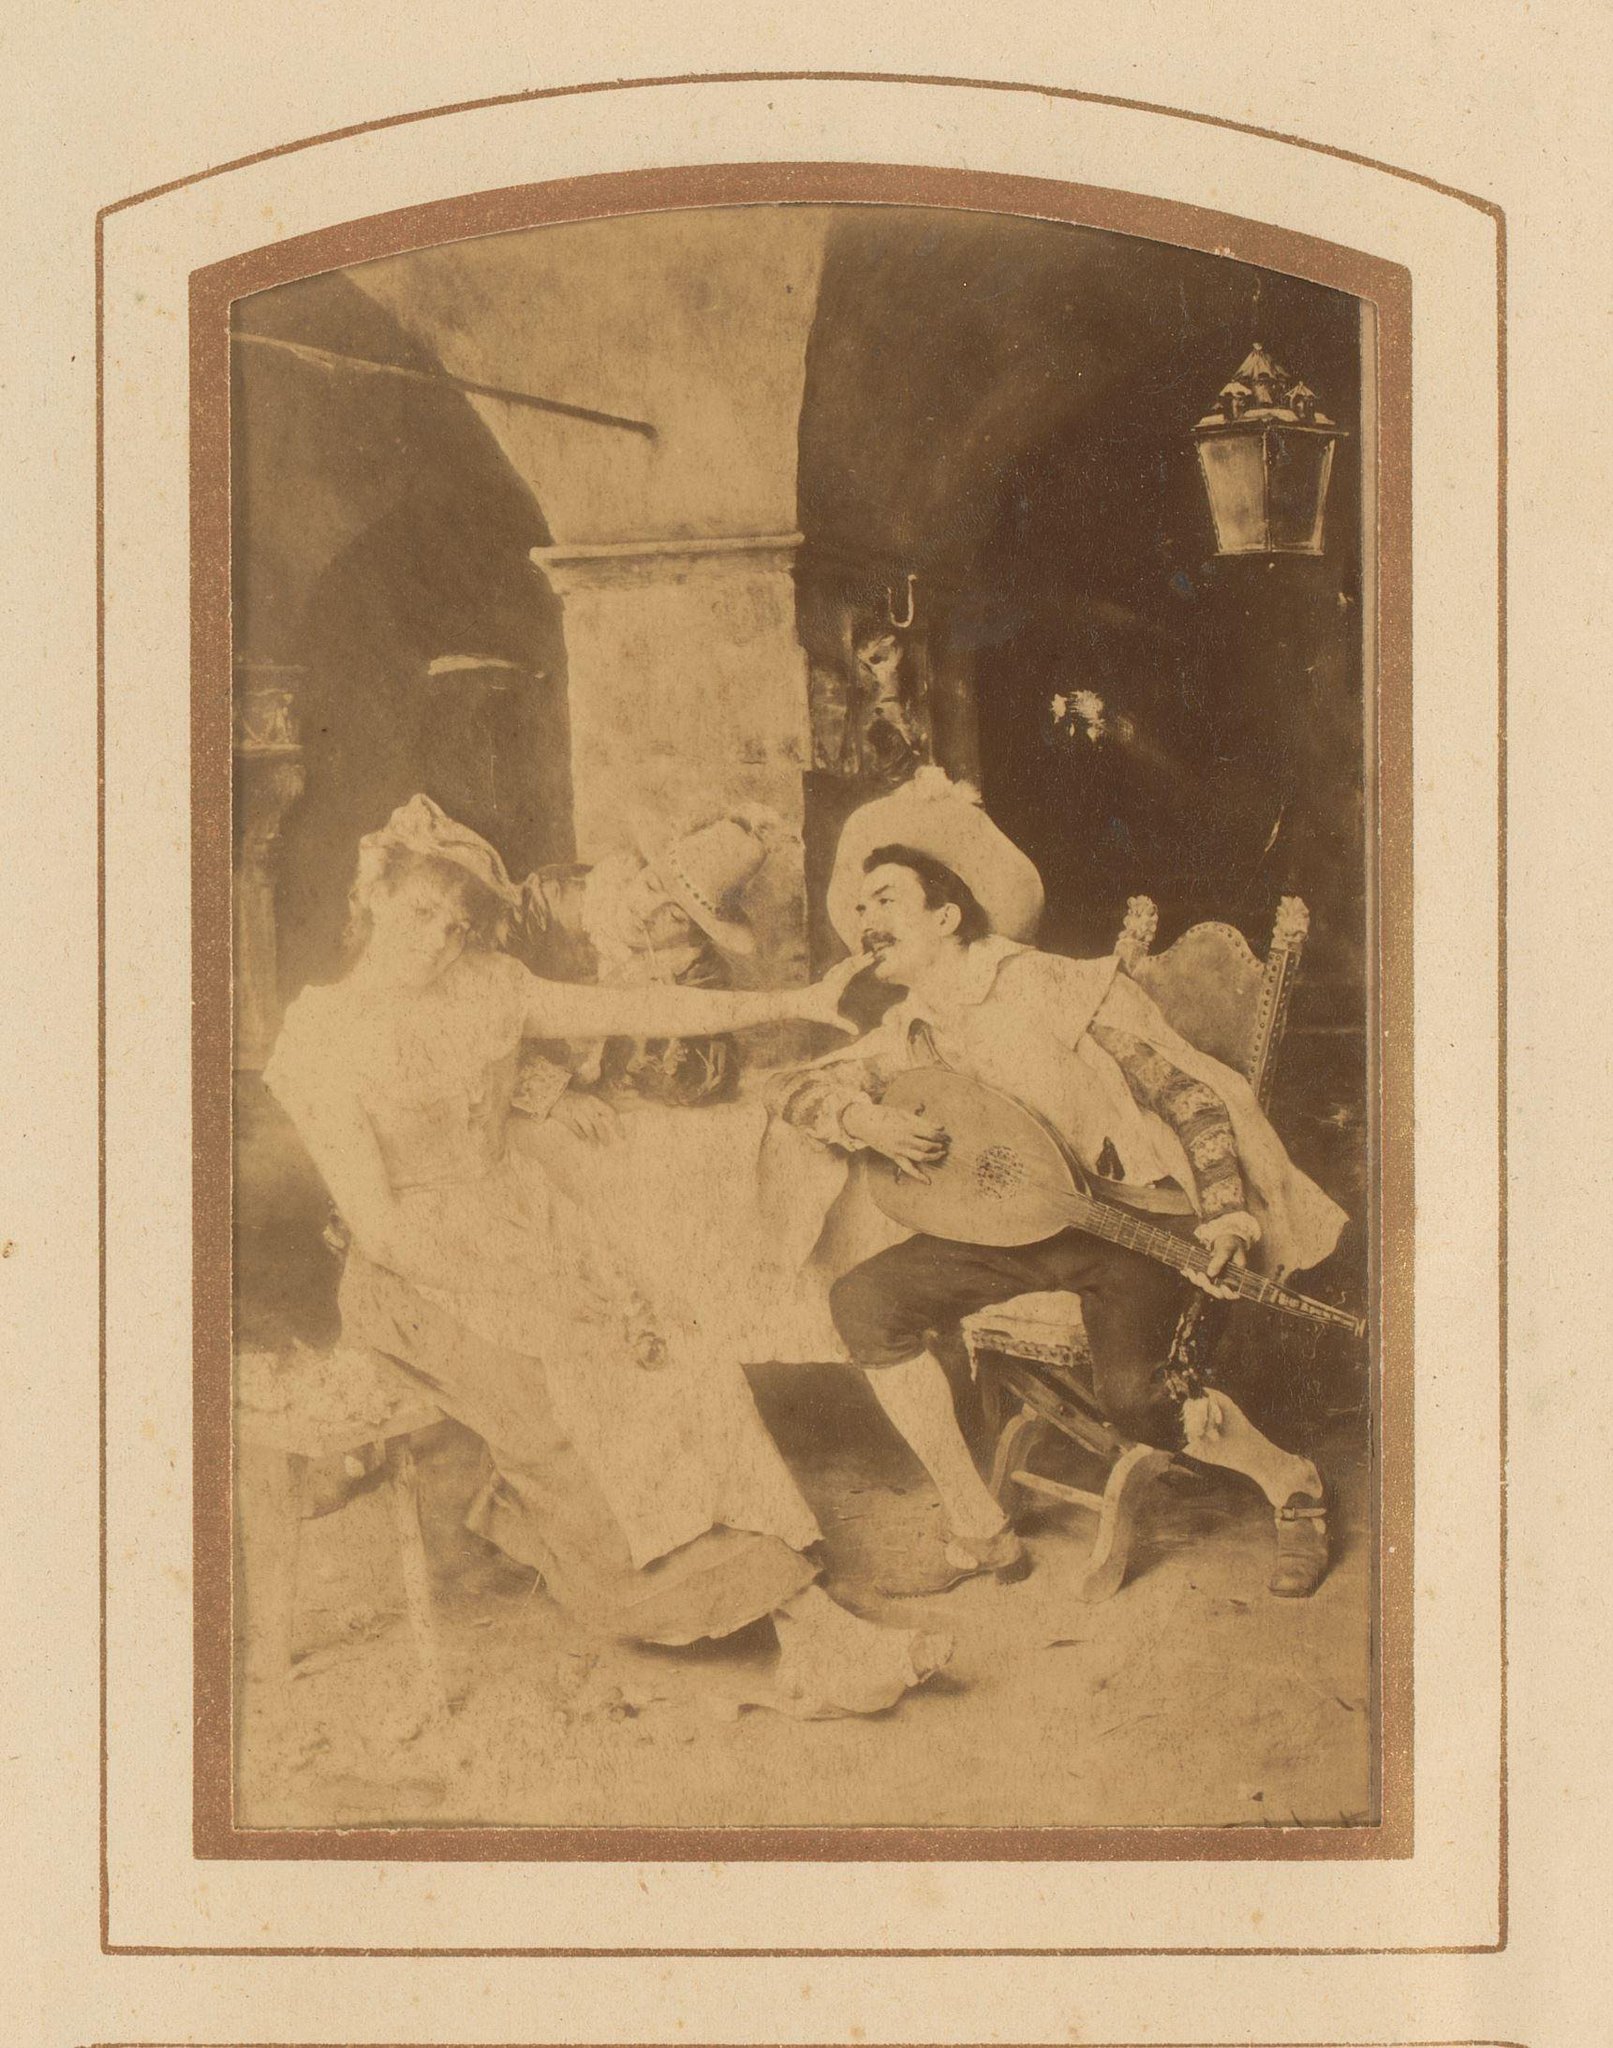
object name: cabinet photograph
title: Fotoreproductie van een schilderij van een man die een schunnig lied speelt voor een vrouw in een kroeg door Federigo Andreotti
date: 1857-1900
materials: cardboard, photographic support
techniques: albumen print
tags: adult woman, string instruments (plucked) (+ artist at work), inn, coffee-house, public house, etc.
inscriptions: inscription: ‘171 - F. Andreotti/ Ein Pikantes Lied’, inscription: ‘Collection Moderne’